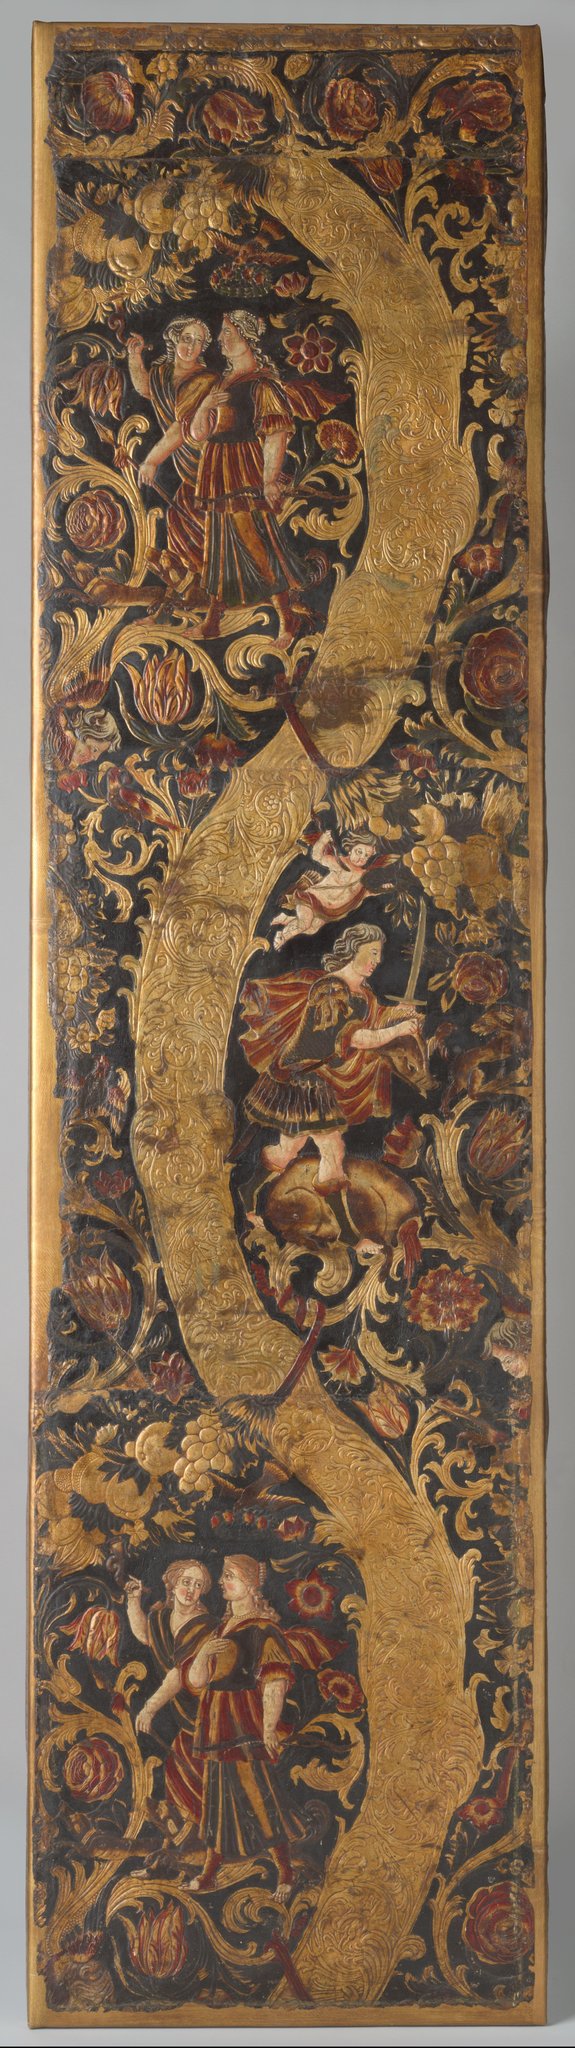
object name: interieuronderdeel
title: Onderdeel van een kamerscherm bekleed met gepolychromeerd goudleer met bloem-, vrucht- en bladranken en mythologische jachtvoorstelling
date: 1630-1650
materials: gilt leather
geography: amsterdam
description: Onderdeel van een kamerscherm bekleed met gepolychromeerd goudleer. Tegen een donkere achtergrond en binnen een kader, gevormd door breed verguld bandwerk en omgeven door bloem, vrucht- en bladranken is een mythologische jachtvoorstelling weergegeven: Atalantha en Meleager. Goudleer ca. 1640. Opmerking: vergelijk ook met BK-NM-12728-A,B.